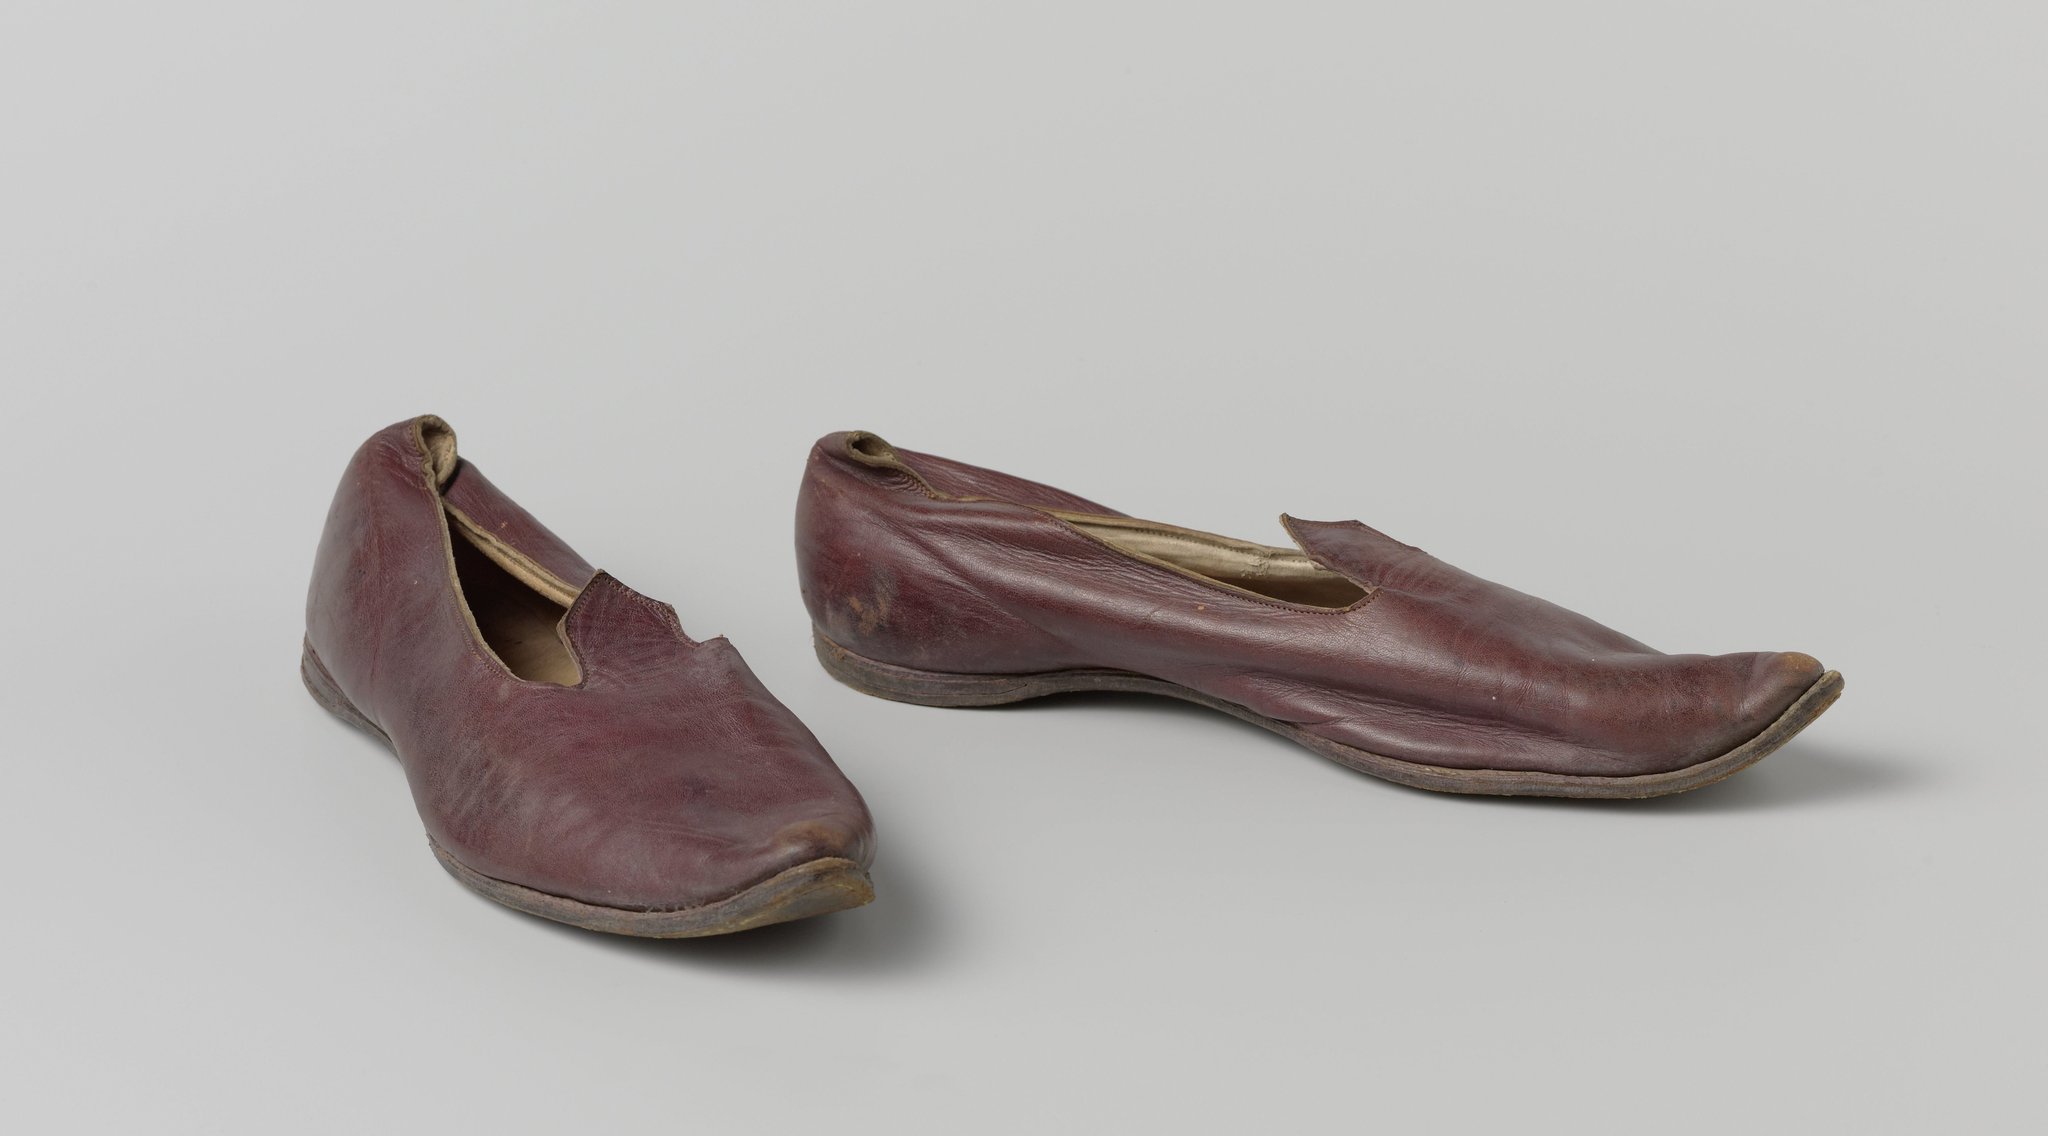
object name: verkleedkleding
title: Leren schoen van Perzisch maskeradekostuum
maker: Anonymous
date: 1913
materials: leather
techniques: quilting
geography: delft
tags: delft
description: 'Hiernevens f.200,- voor je pak...'; citaat uit brief van H.M.A.F. Six-Bosch Reitz aan haar zoon, Collectie Six Amsterdam, inv. 51993. Zie ook foto's van Six in kostuum in Collectie Six, Amsterdam, inv. 51993 en 'Regenten gekleed', afb.42, p.51..